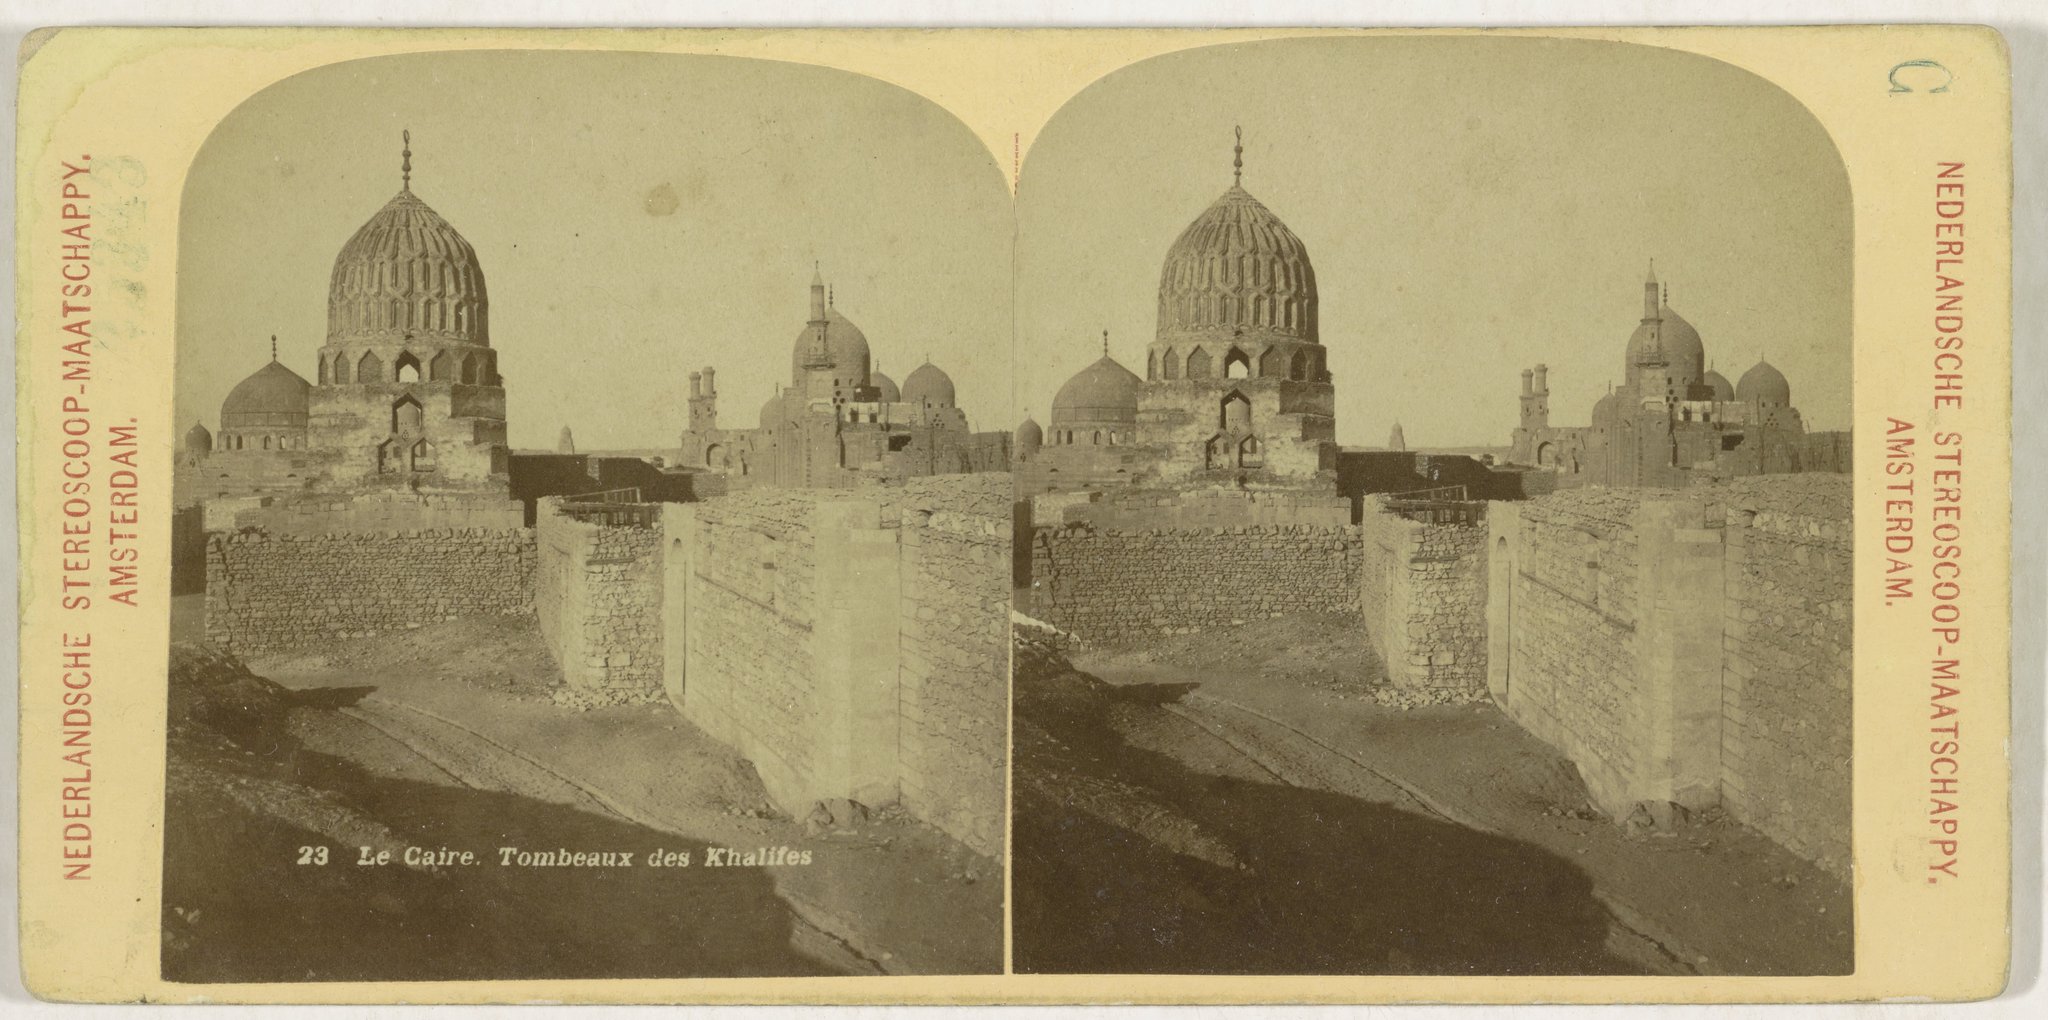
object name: stereograph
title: Le Caire. Tombeaux des Khalifes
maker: j.g. beers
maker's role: fotograaf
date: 1873-1890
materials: cardboard, paper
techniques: albumen print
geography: cairo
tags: grave, tomb, slavery; serfs and enslaved persons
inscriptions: number: ‘23’, number: ‘25343’, inscription: ‘C’